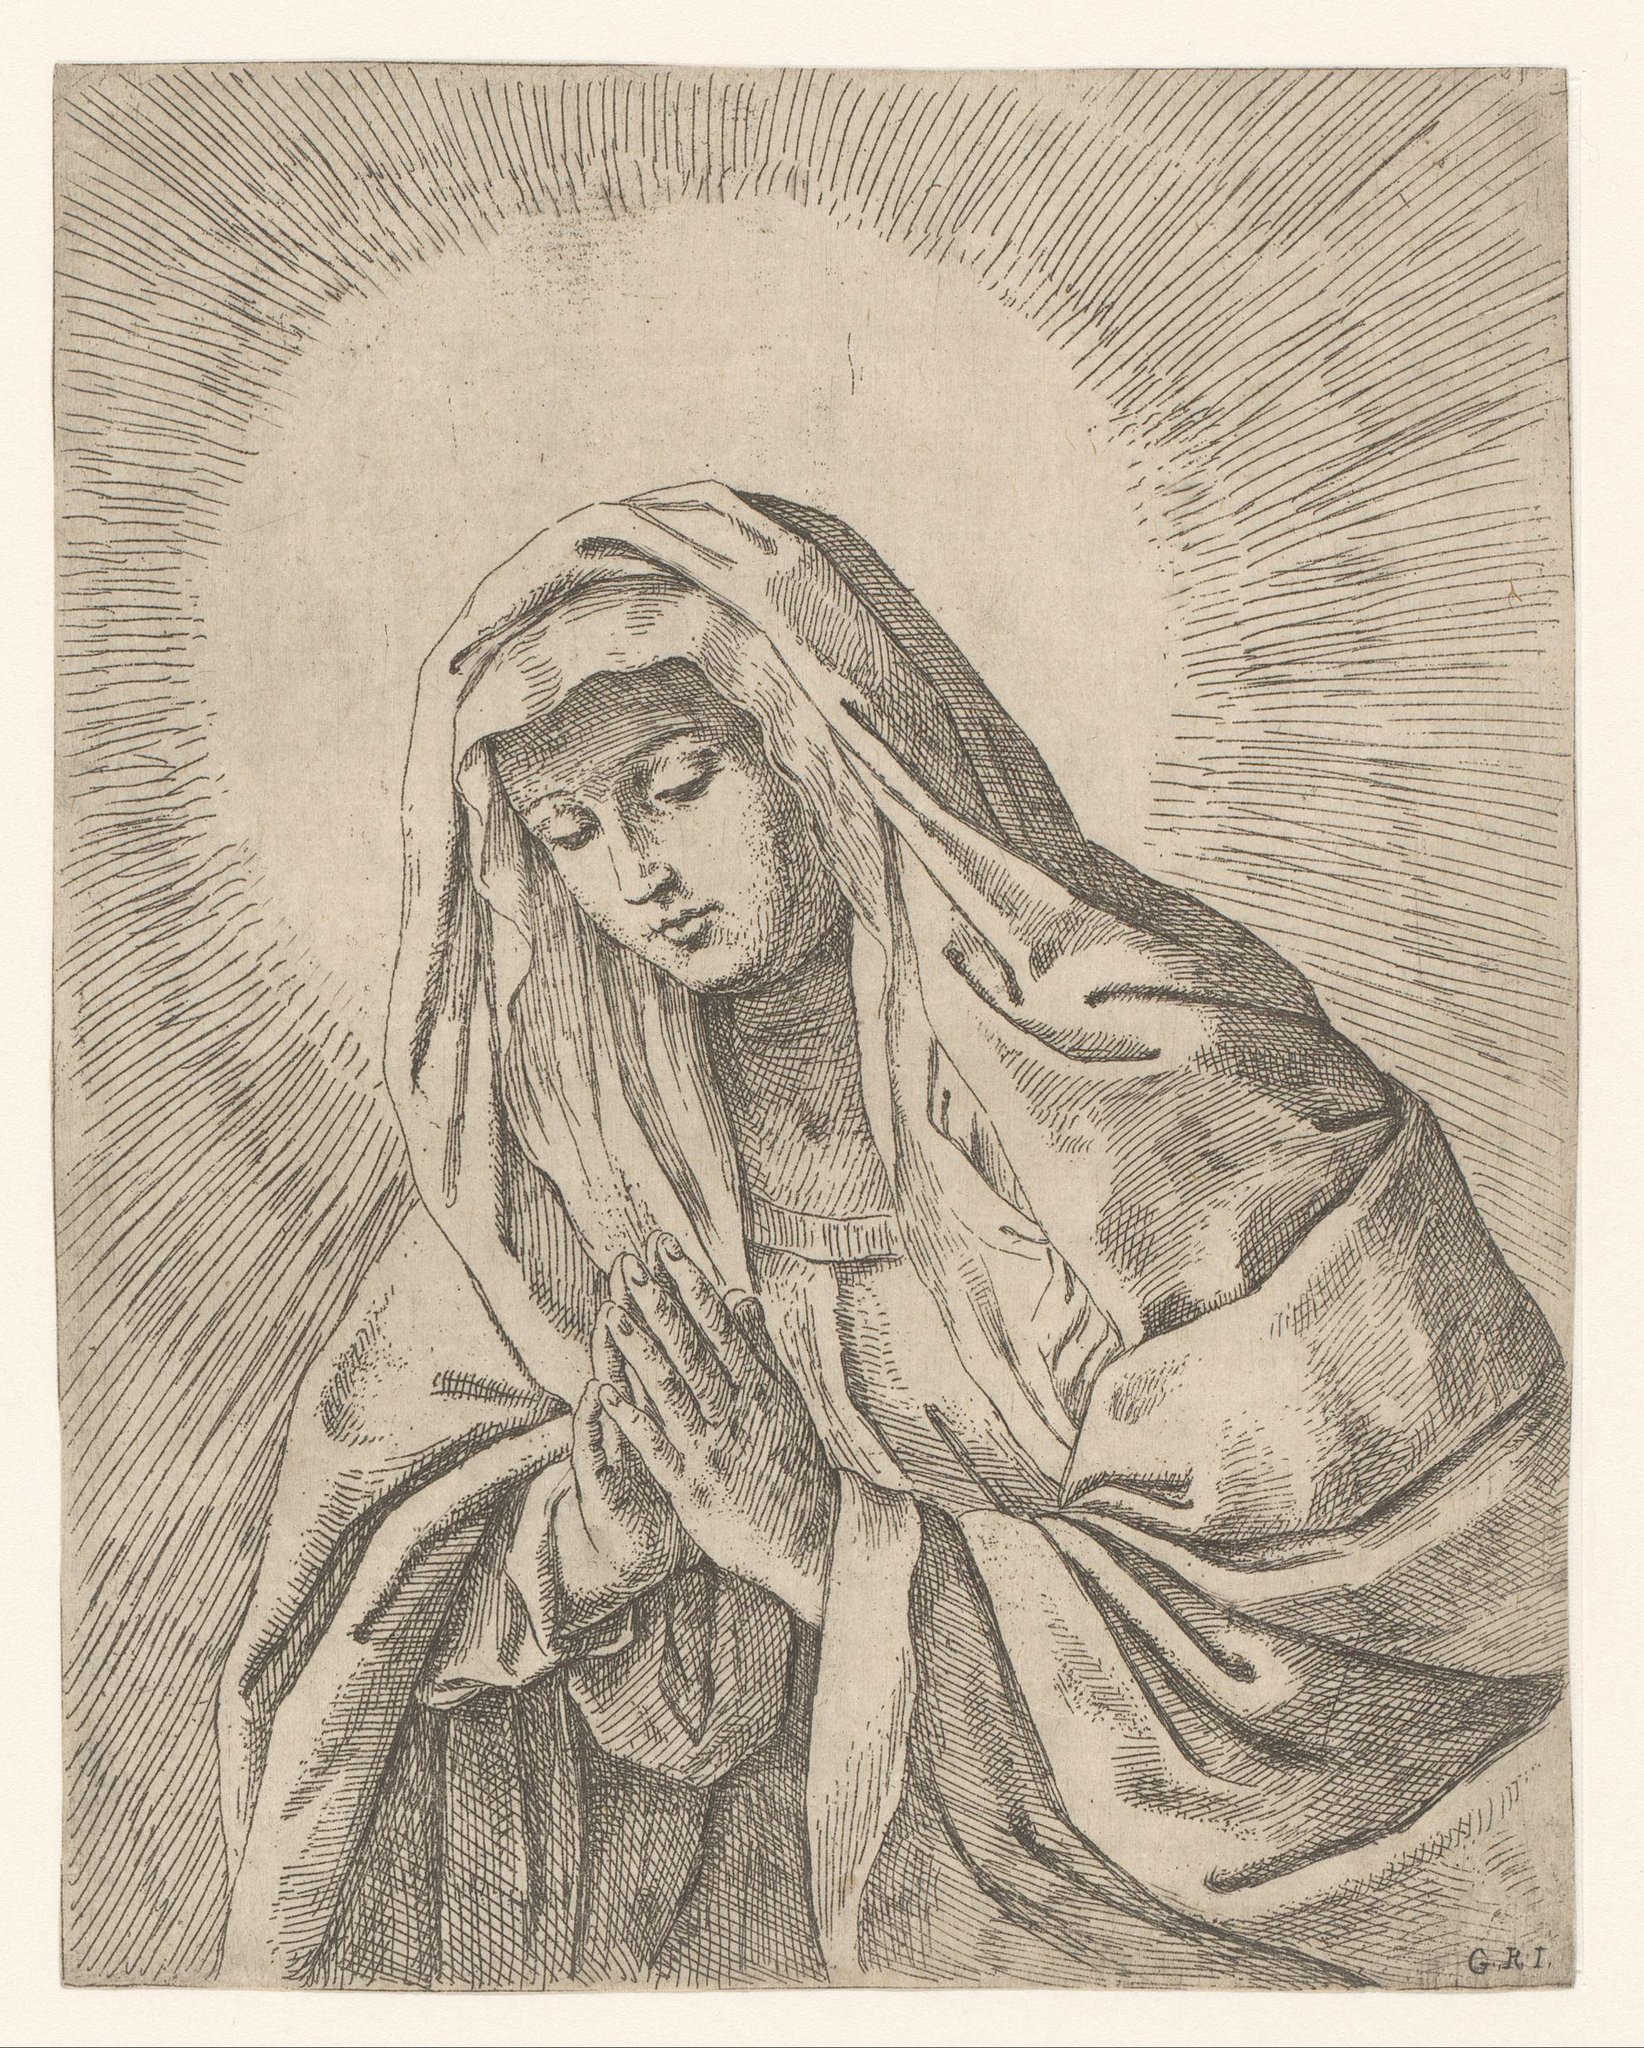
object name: print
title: Maria in gebed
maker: girolamo scarselli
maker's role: painter, print maker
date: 1660-1680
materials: paper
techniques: etching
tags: mary (without the christ-child)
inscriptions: collector's mark: ‘Zwarte cirkel met onleesbare tekst.’, collector's mark: Lugt 2228